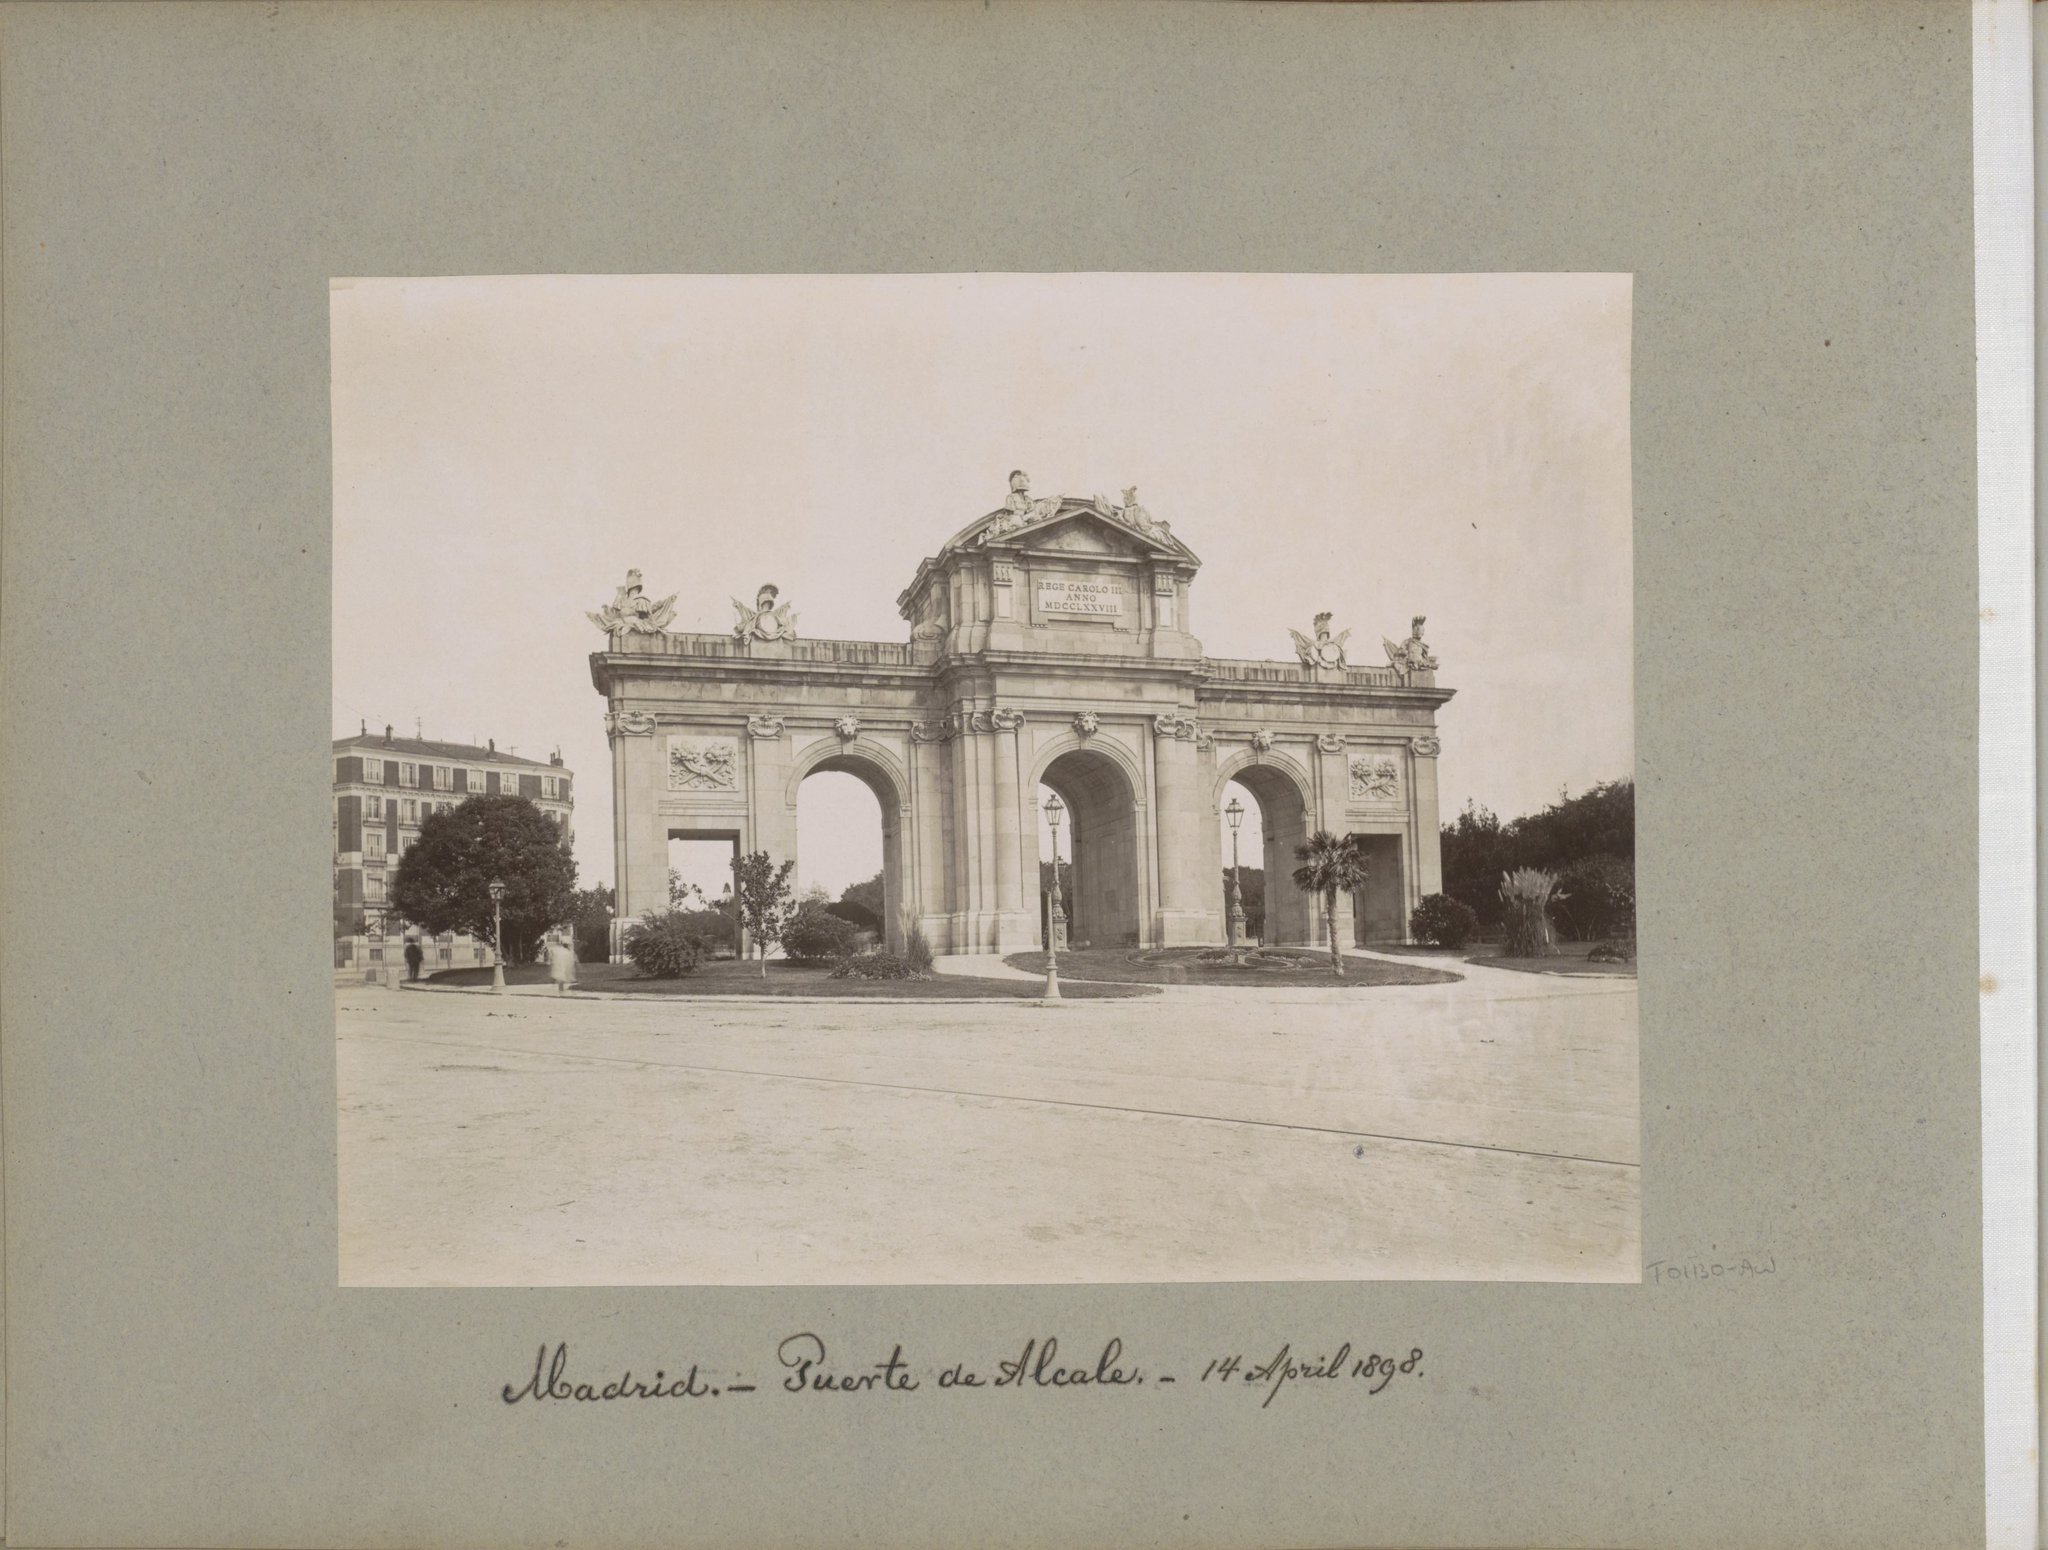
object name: photograph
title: Puerta de Alcalá in Madrid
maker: Anonymous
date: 1880-1898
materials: paper, photographic support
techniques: albumen print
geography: madrid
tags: city-gate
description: Onderdeel van Reisalbum met foto's van bezienswaardigheden in Frankrijk, Spanje, Italië, Duitsland, Zwitserland en Oostenrijk.